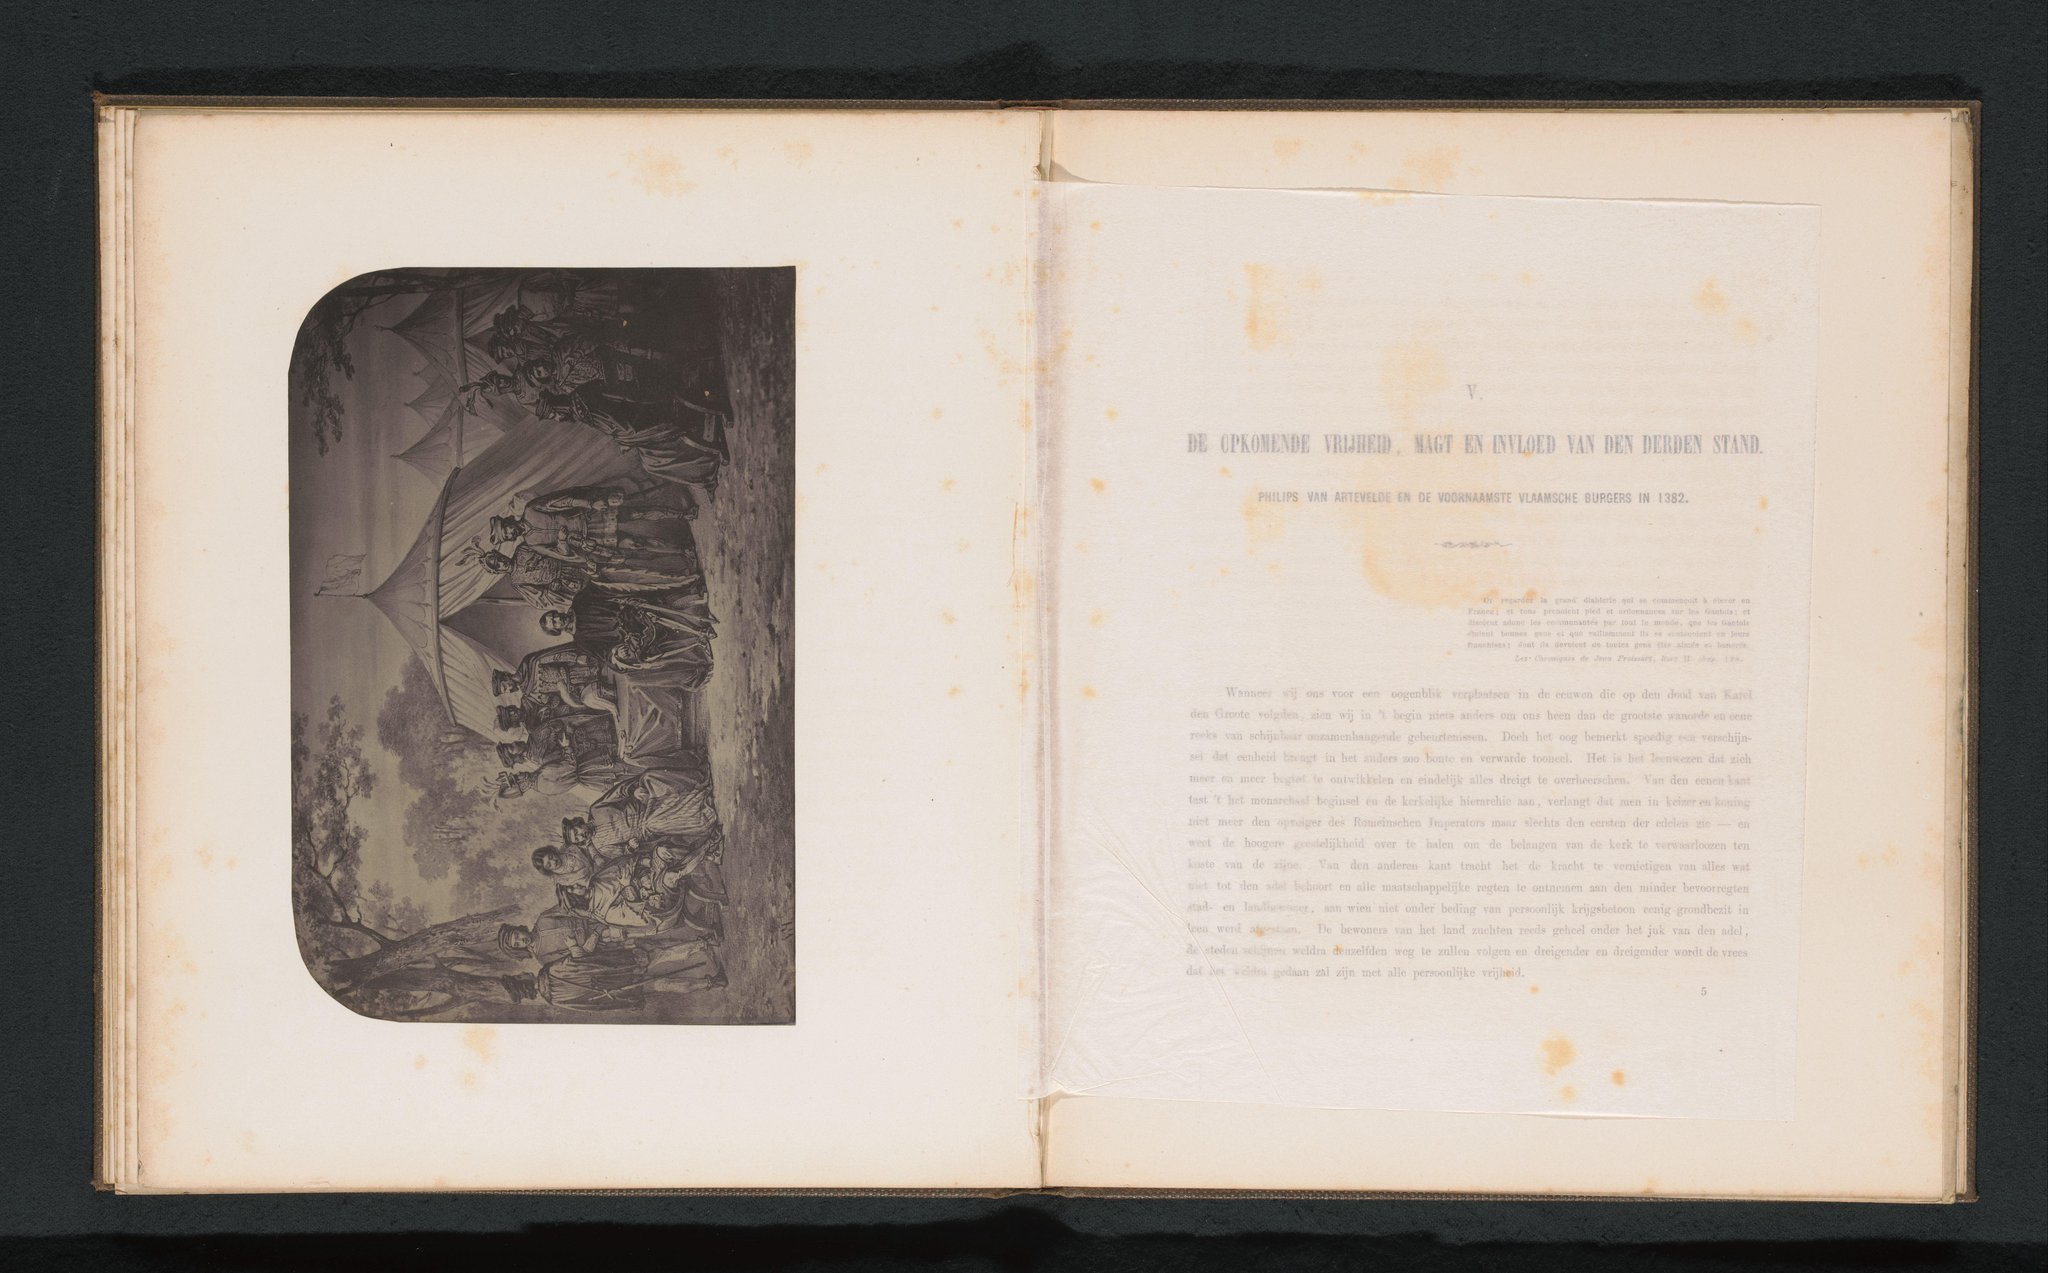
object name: photograph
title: Fotoreproductie van een prent van Filips van Artevelde en de voornaamste Vlaamse burgers in 1382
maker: Anonymous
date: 1856-1861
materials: photographic support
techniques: albumen print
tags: meeting, assembly